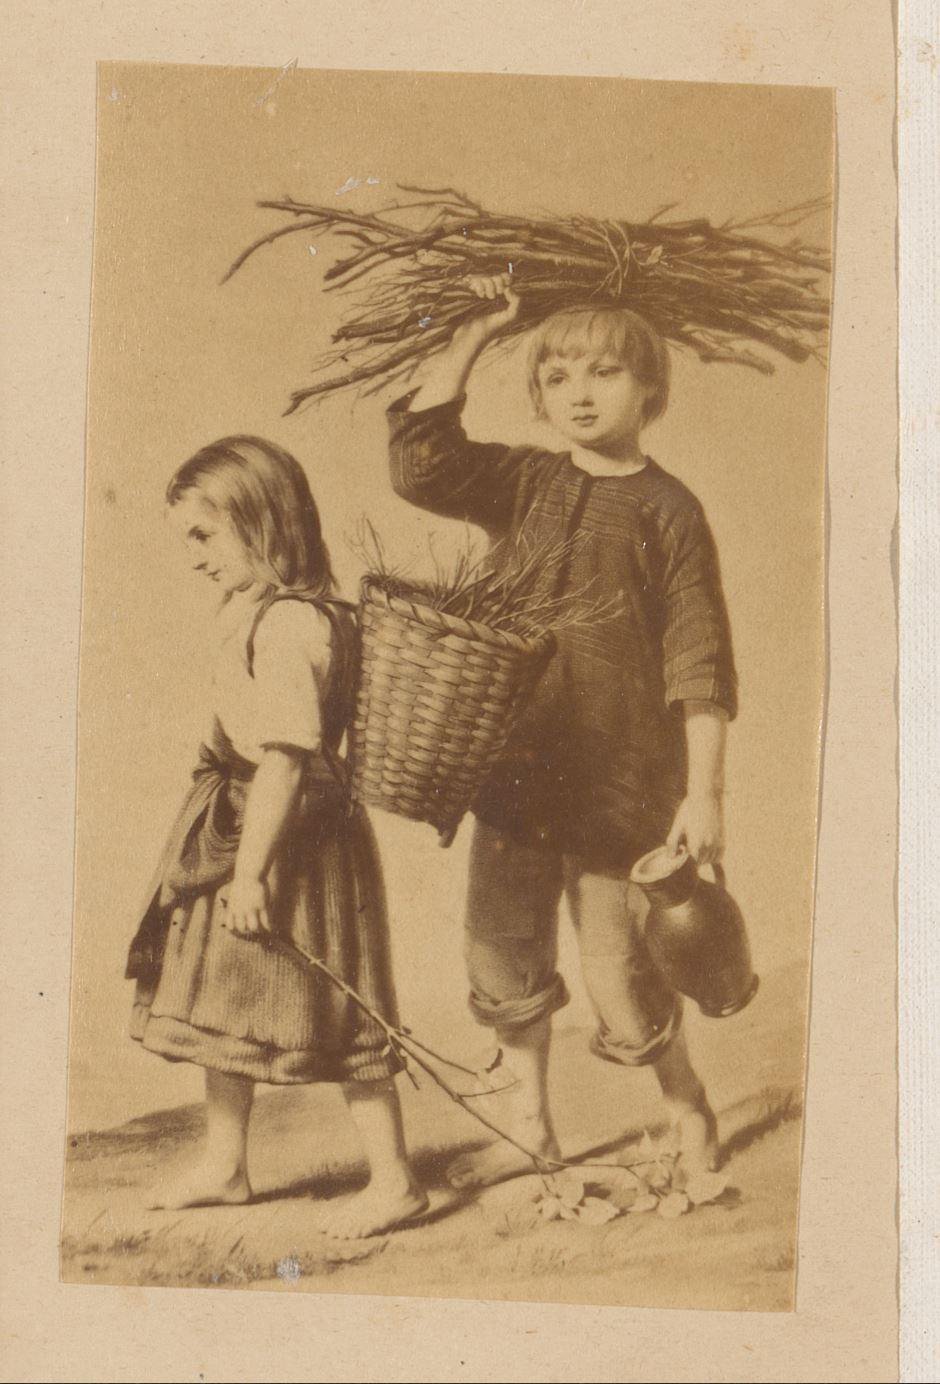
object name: photograph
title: Fotoreproductie van een schilderij met twee kinderen die hout sprokkelen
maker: Anonymous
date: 1875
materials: photographic support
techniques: albumen print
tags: woodgathering, woodgatherer